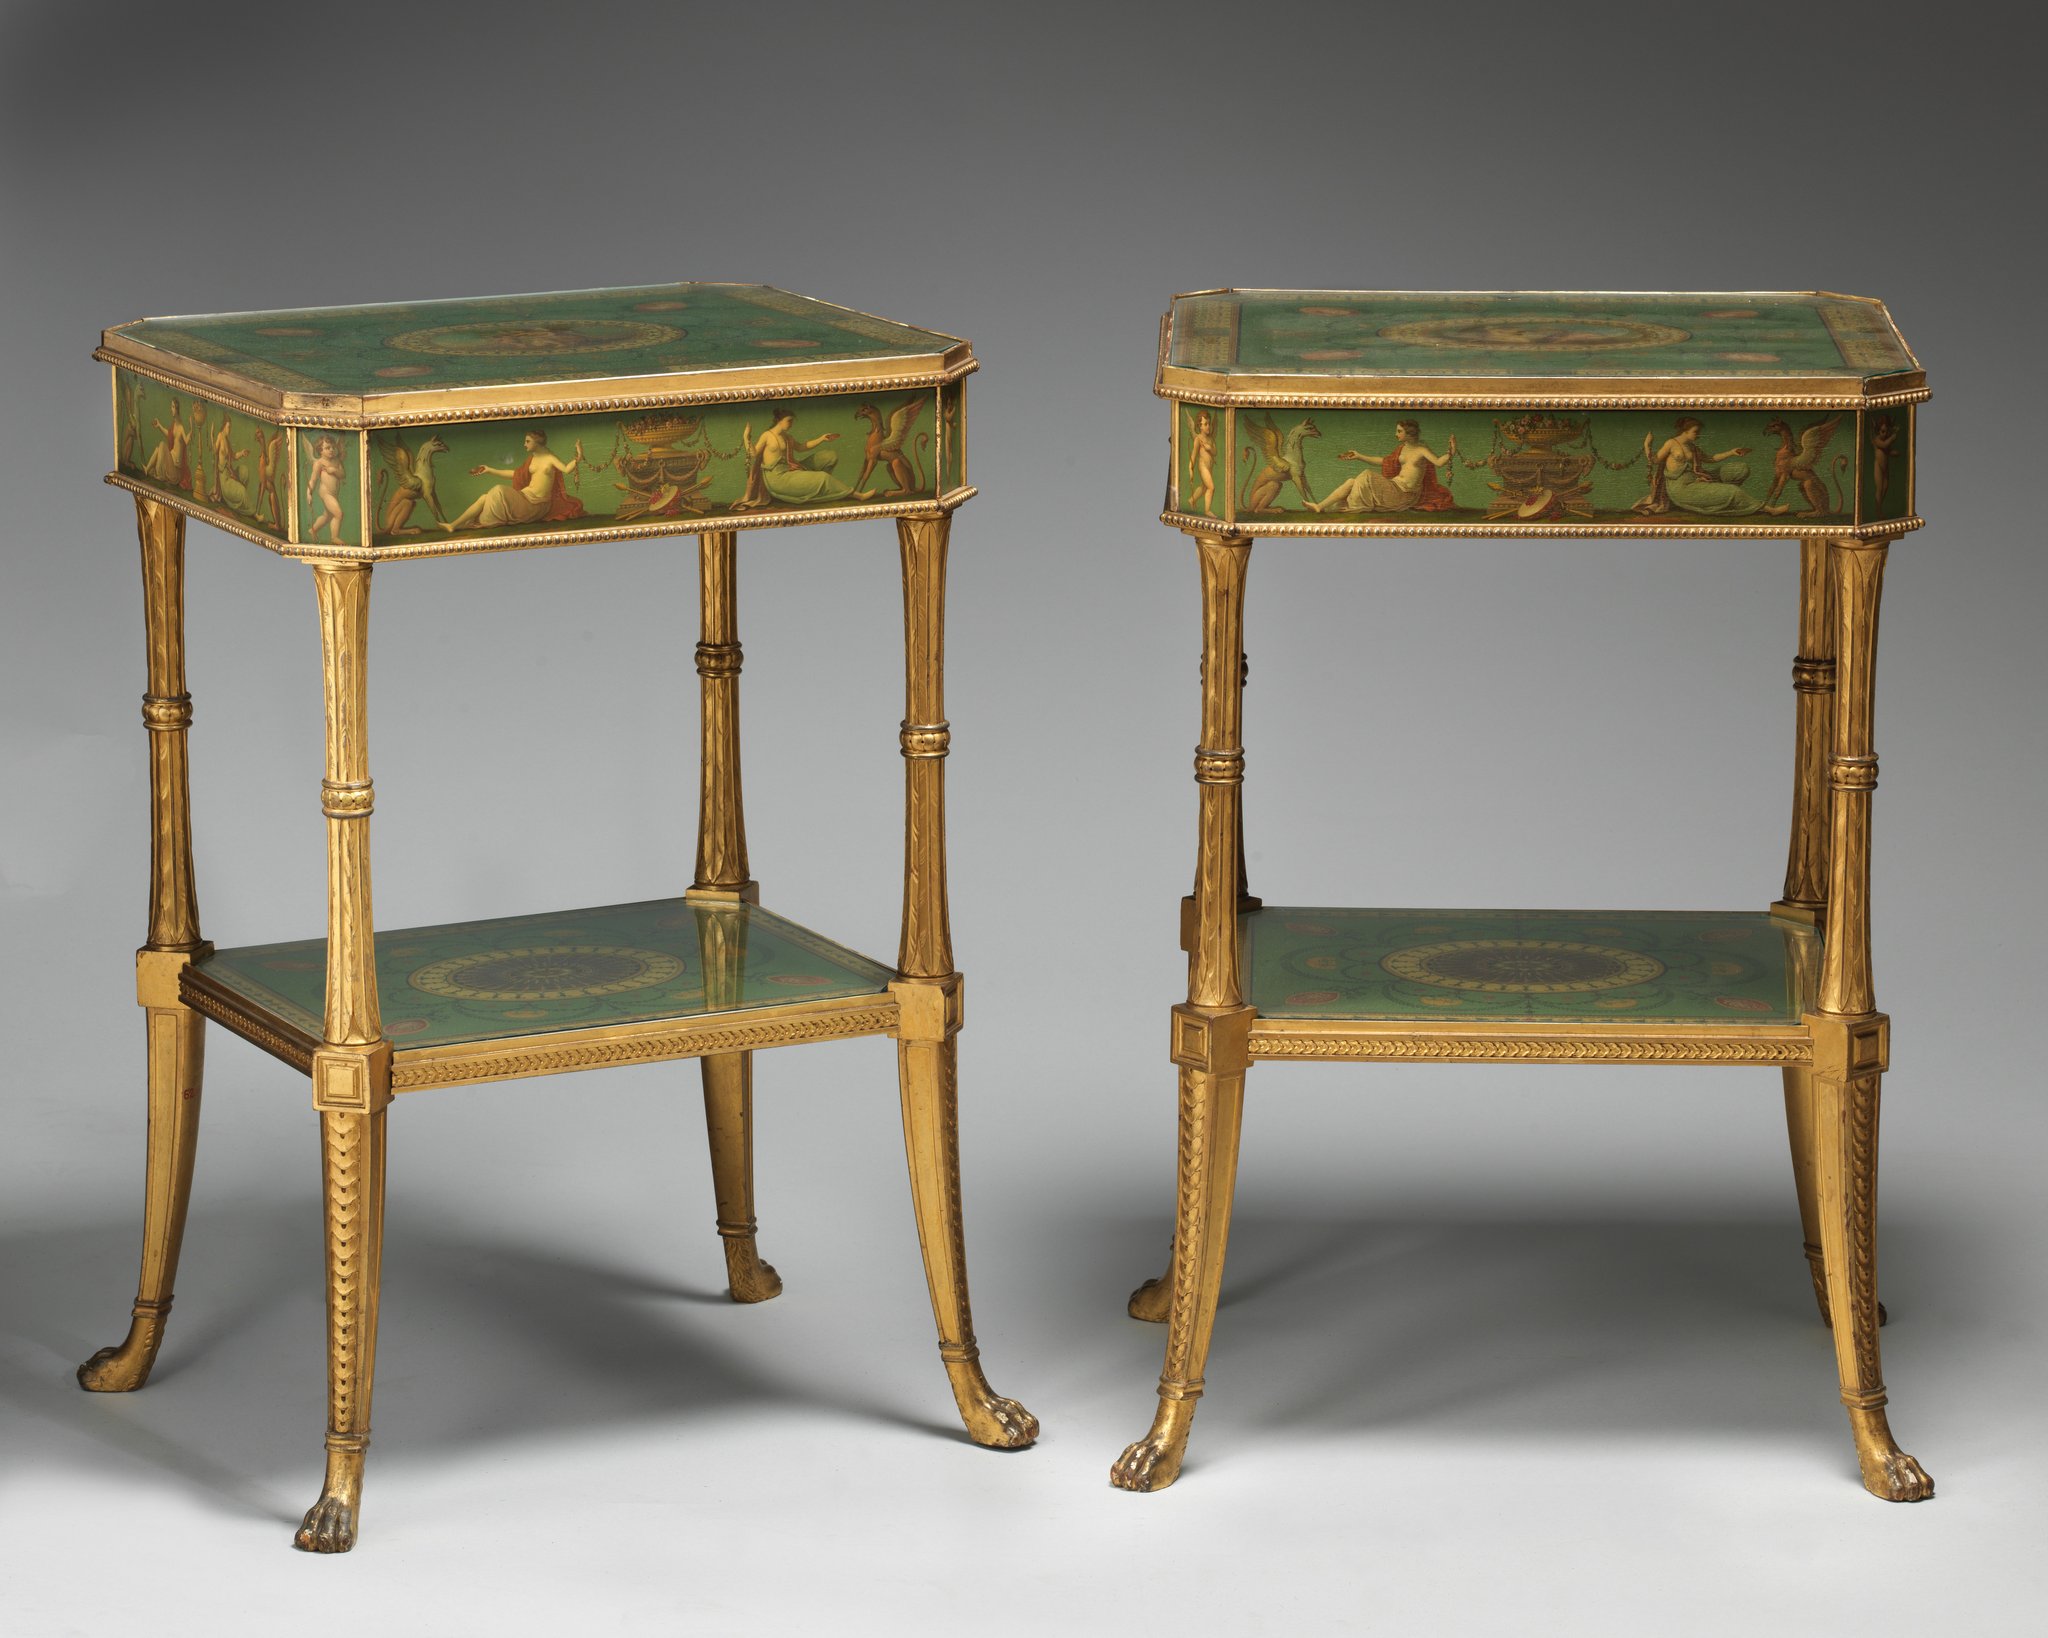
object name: table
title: Pair of tables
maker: james stuart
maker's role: maker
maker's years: 1700-1800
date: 1701-1800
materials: glaze, wood, oil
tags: cupid,psyche,griffins